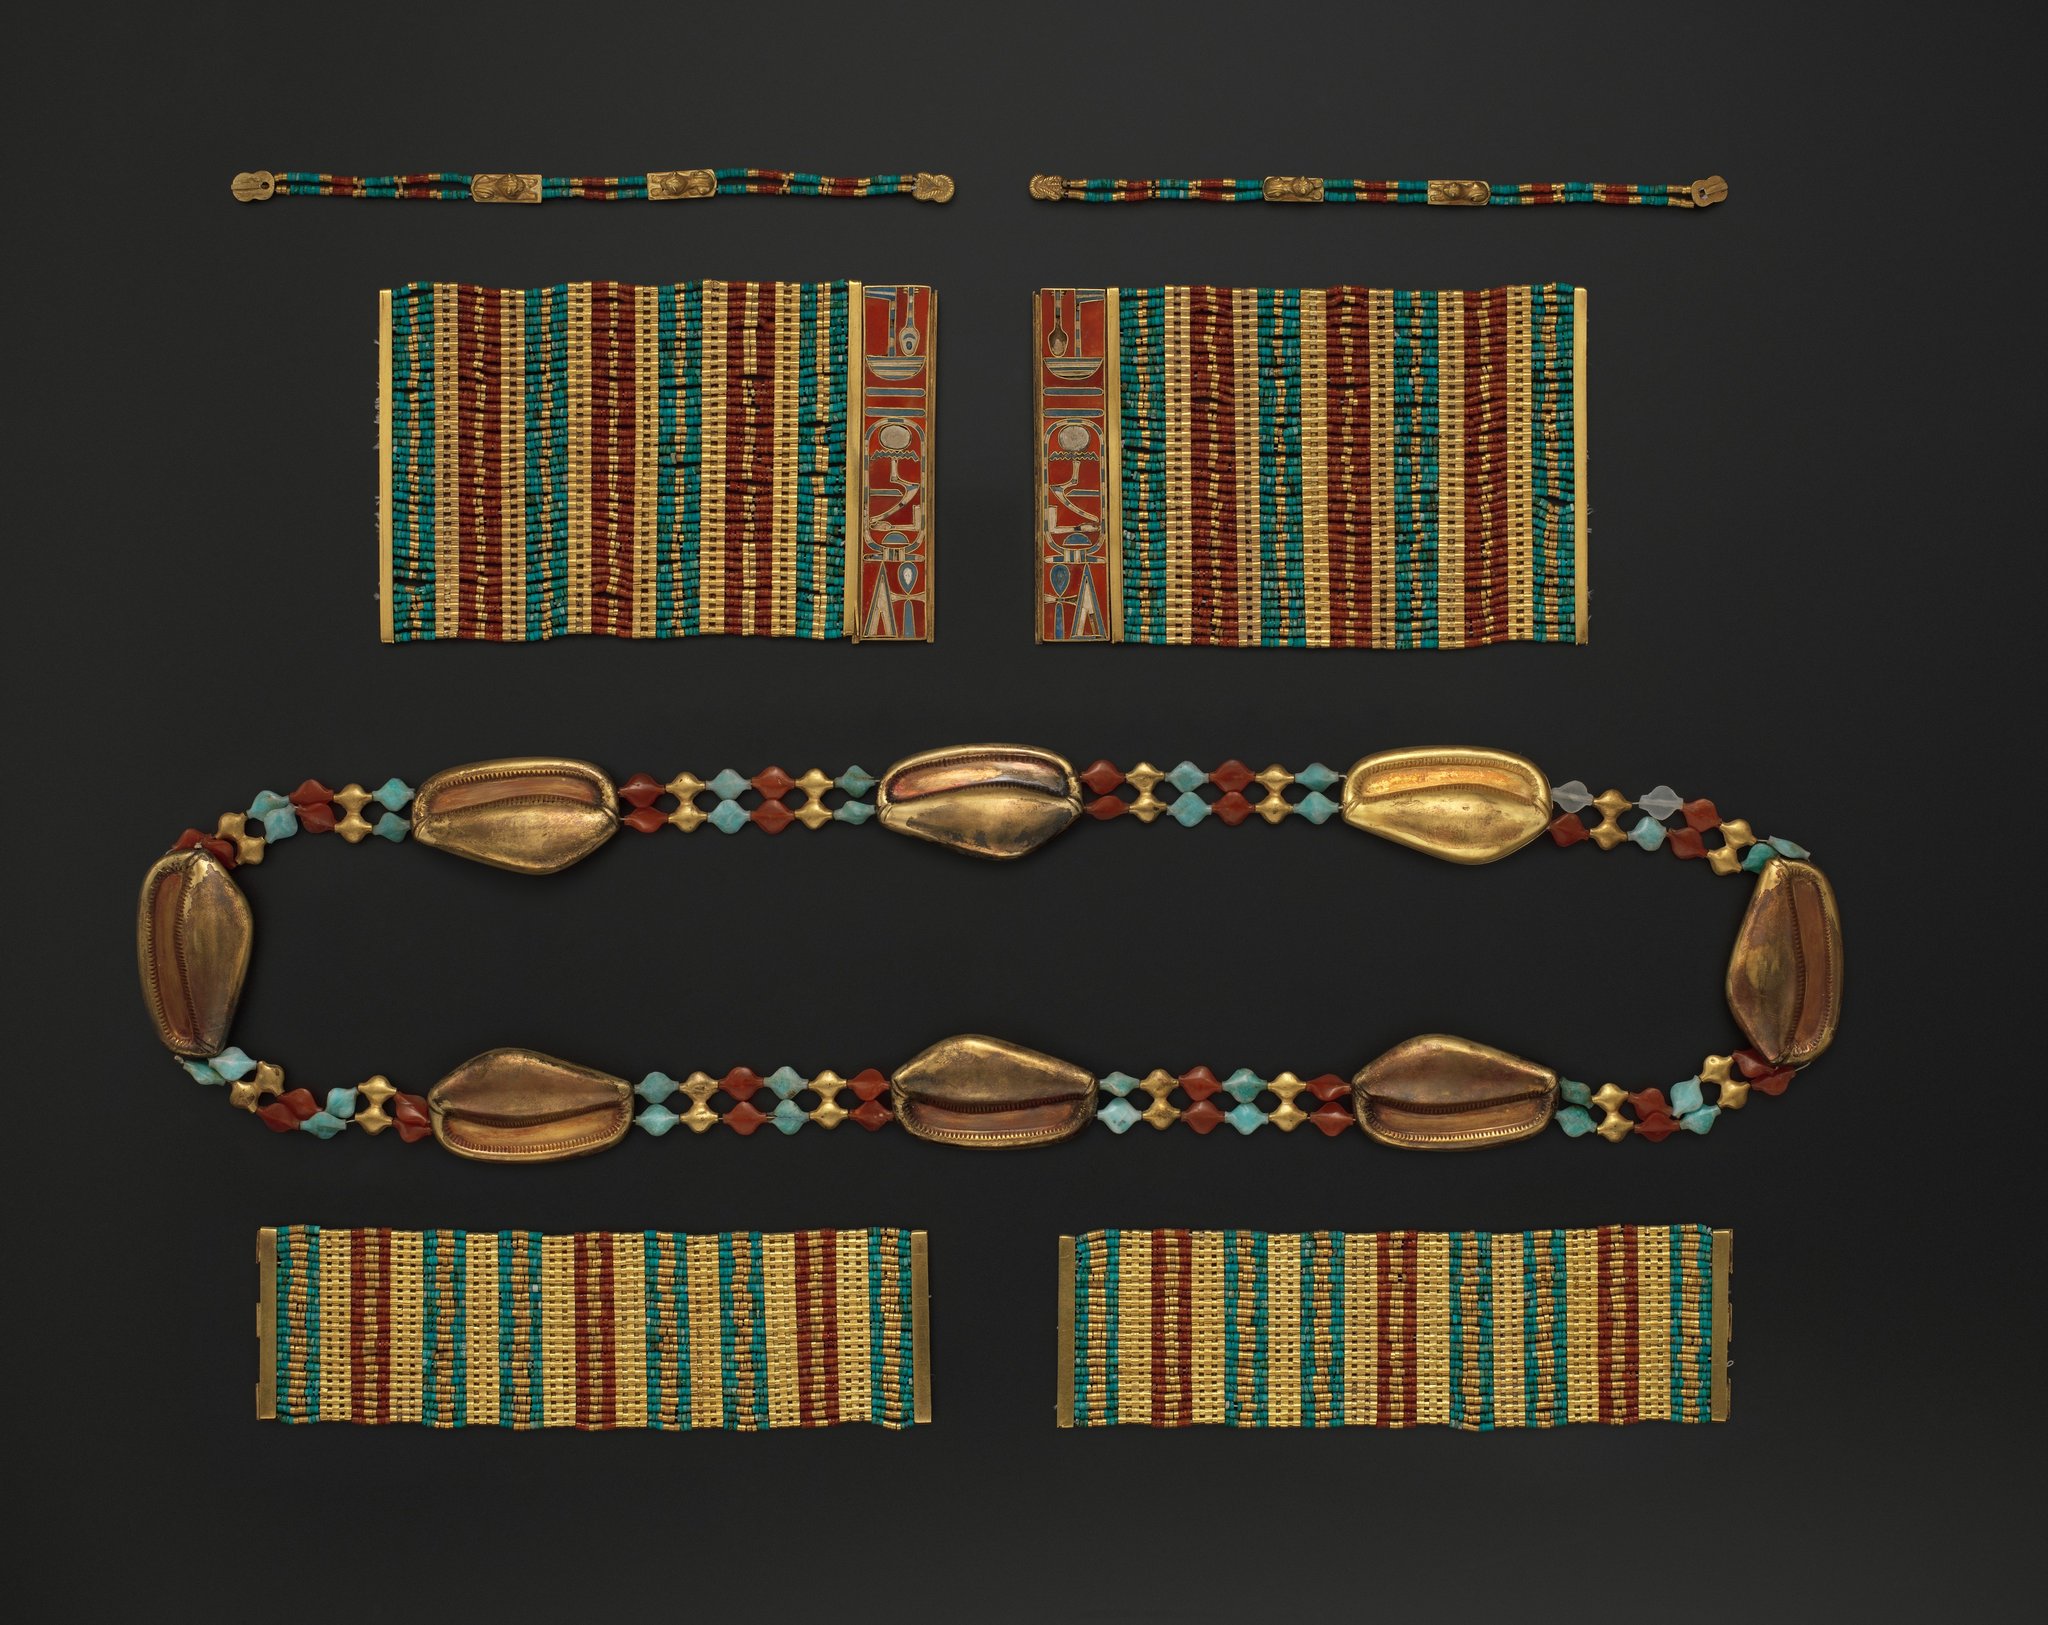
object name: girdle, bracelet, anklet, sithathoryunet view jewelry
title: Cowrie Shell Girdle, Lion Bracelets, Bracelets with the Name of Amenemhat III, and Anklets of Princess Sithathoryunet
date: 1887-1813 BCE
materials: gemstone, silver alloy, gold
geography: egypt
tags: sithathoryunet-jewelry